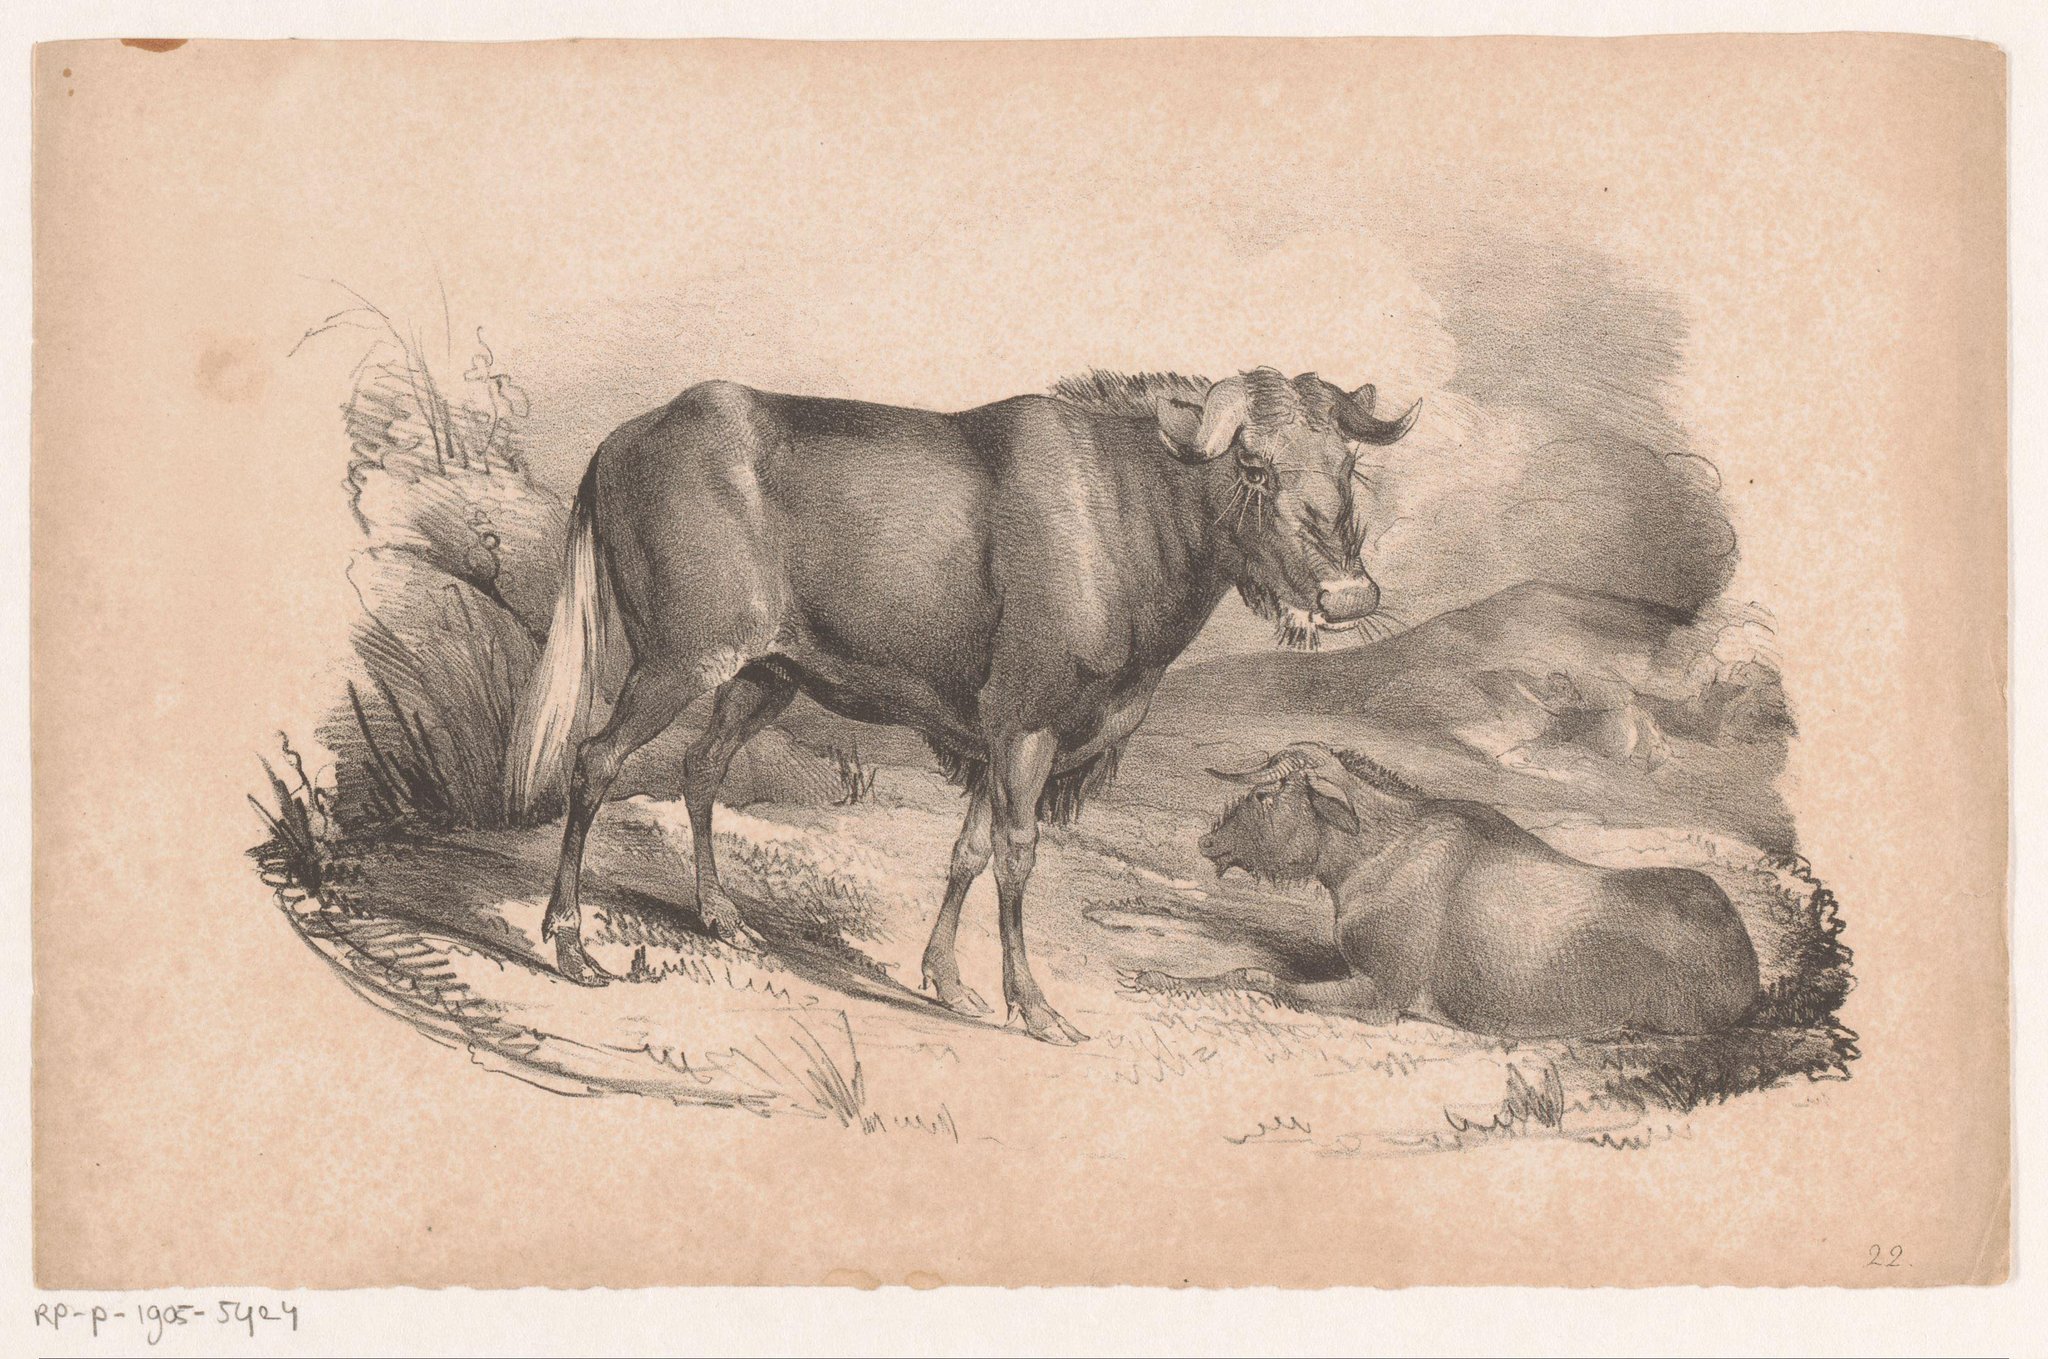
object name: print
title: Twee gnoes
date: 1842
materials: paper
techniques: lithograph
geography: netherlands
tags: hoofed animals: gnu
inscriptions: collector's mark: Lugt 2228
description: Deze prent verscheen in: Schlegel, H. De Diergaarde en het Museum van het genootschap Natura Artis Magistra te Amsterdam. Amsterdam, M. Westerman & Zoon, 1842, t. o. p. 169.